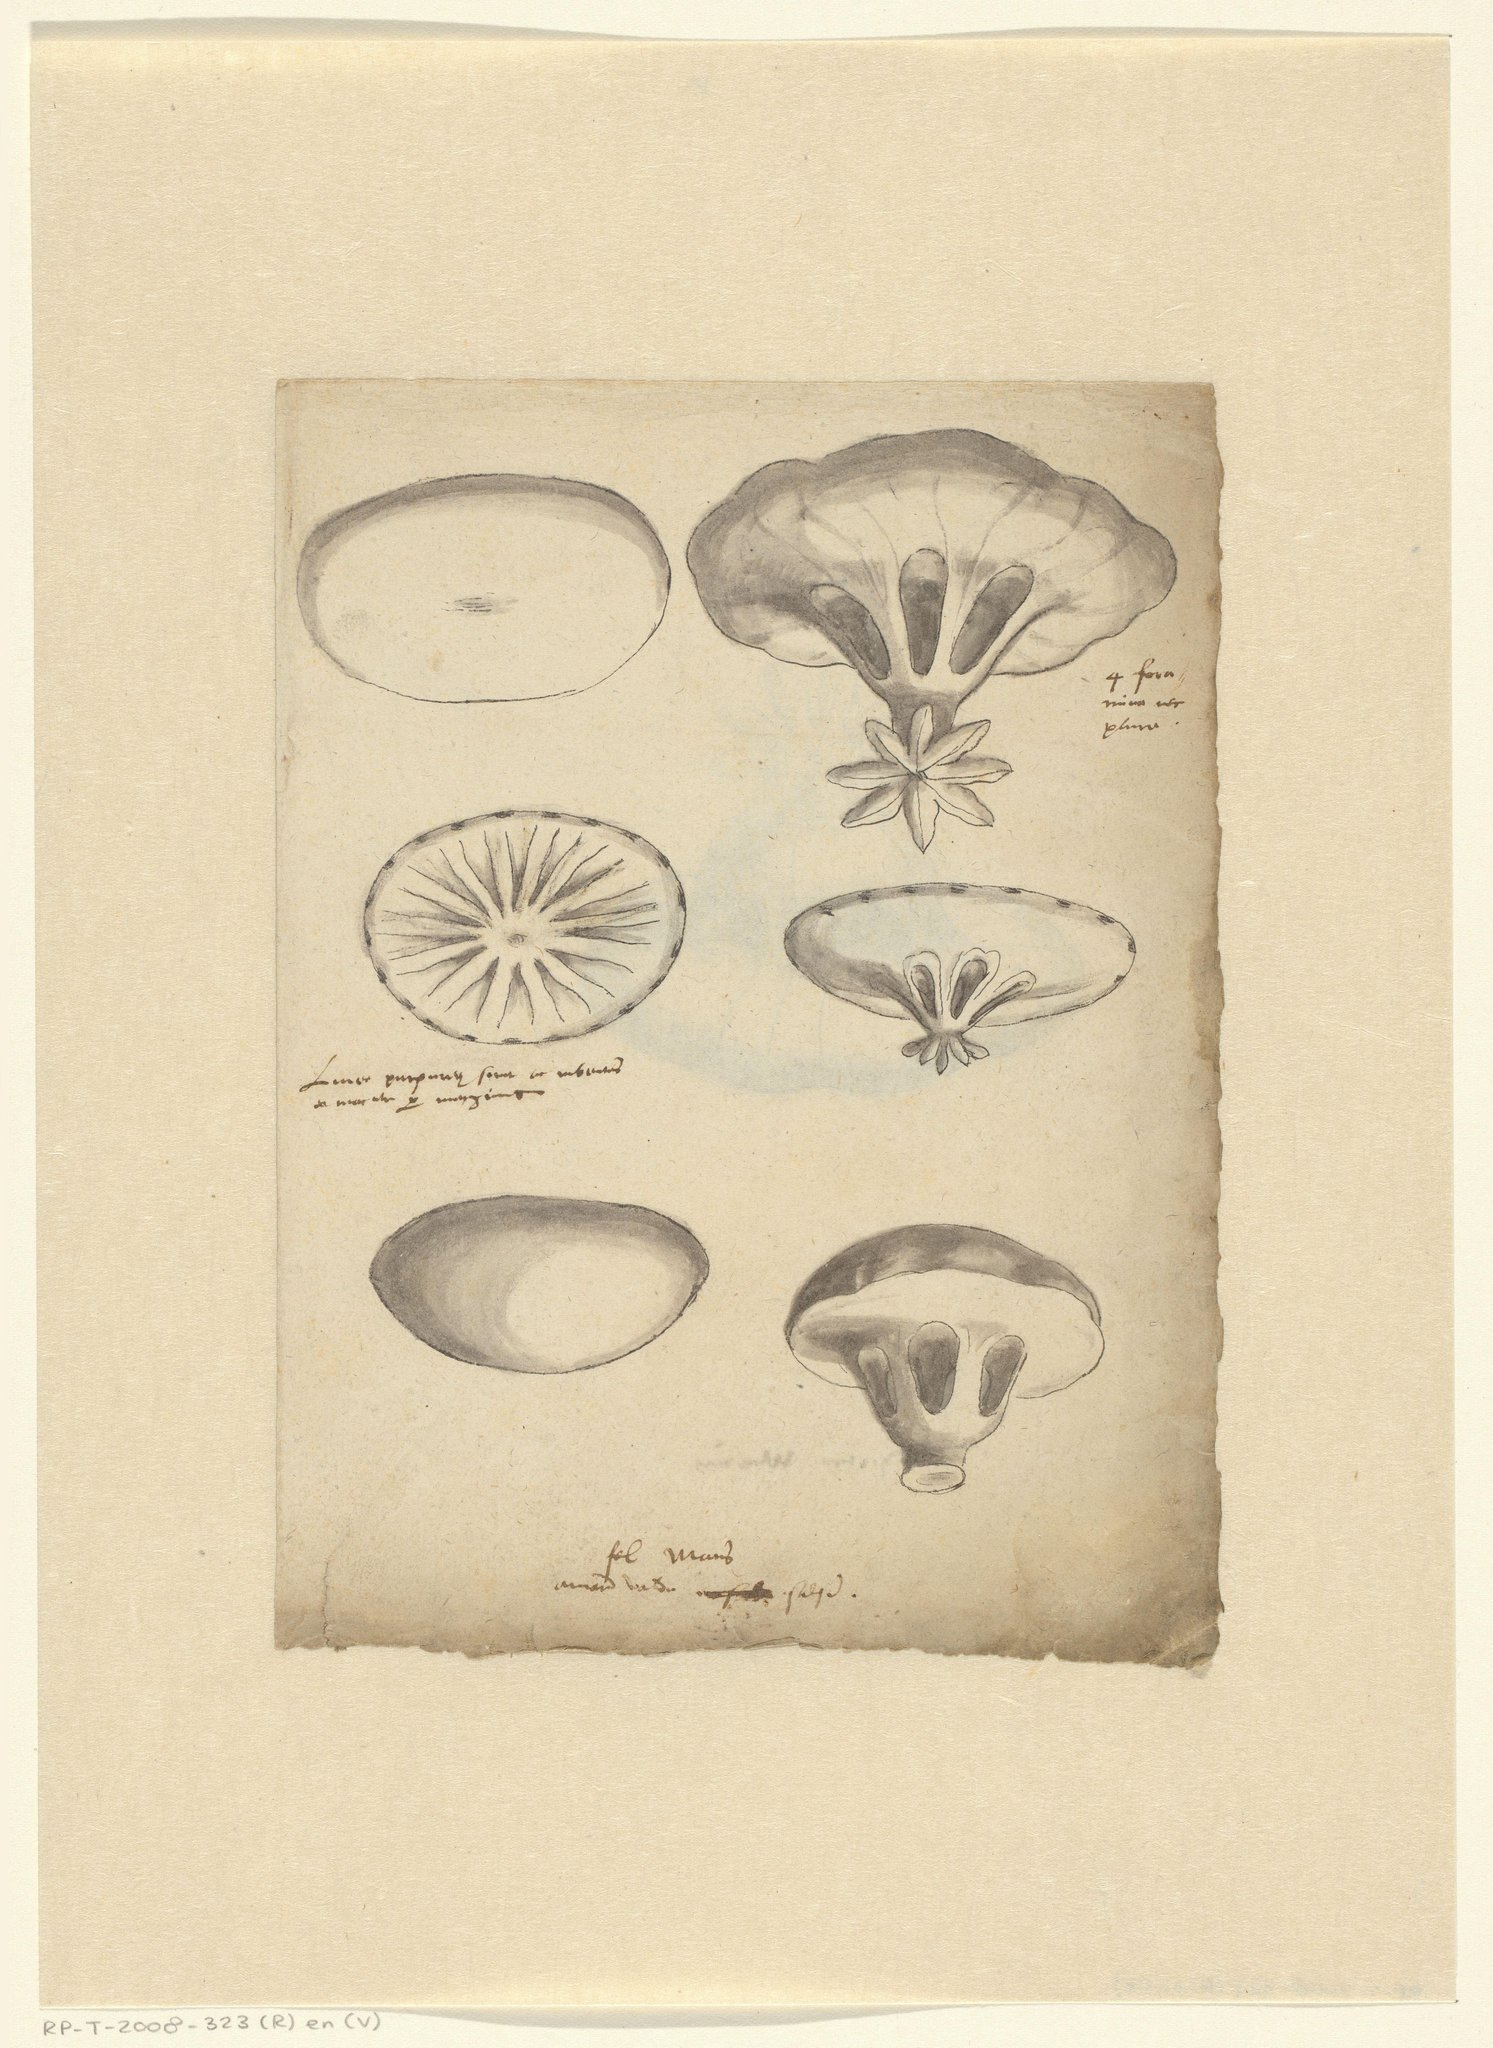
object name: drawing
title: Study sheet with jelly fish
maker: Anonymous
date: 1575-1599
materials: ink, paper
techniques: brush, pen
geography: netherlands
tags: coelenterata: jelly-fish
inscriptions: inscription: ‘Lineae purpureae sunt ac rubescentes/ et maculae per marginem’, inscription: ‘4 fora-/ mina nec/ plura’, inscription: ‘Lineae purpureae sunt ac rubescentes/ et maculae per marginem’